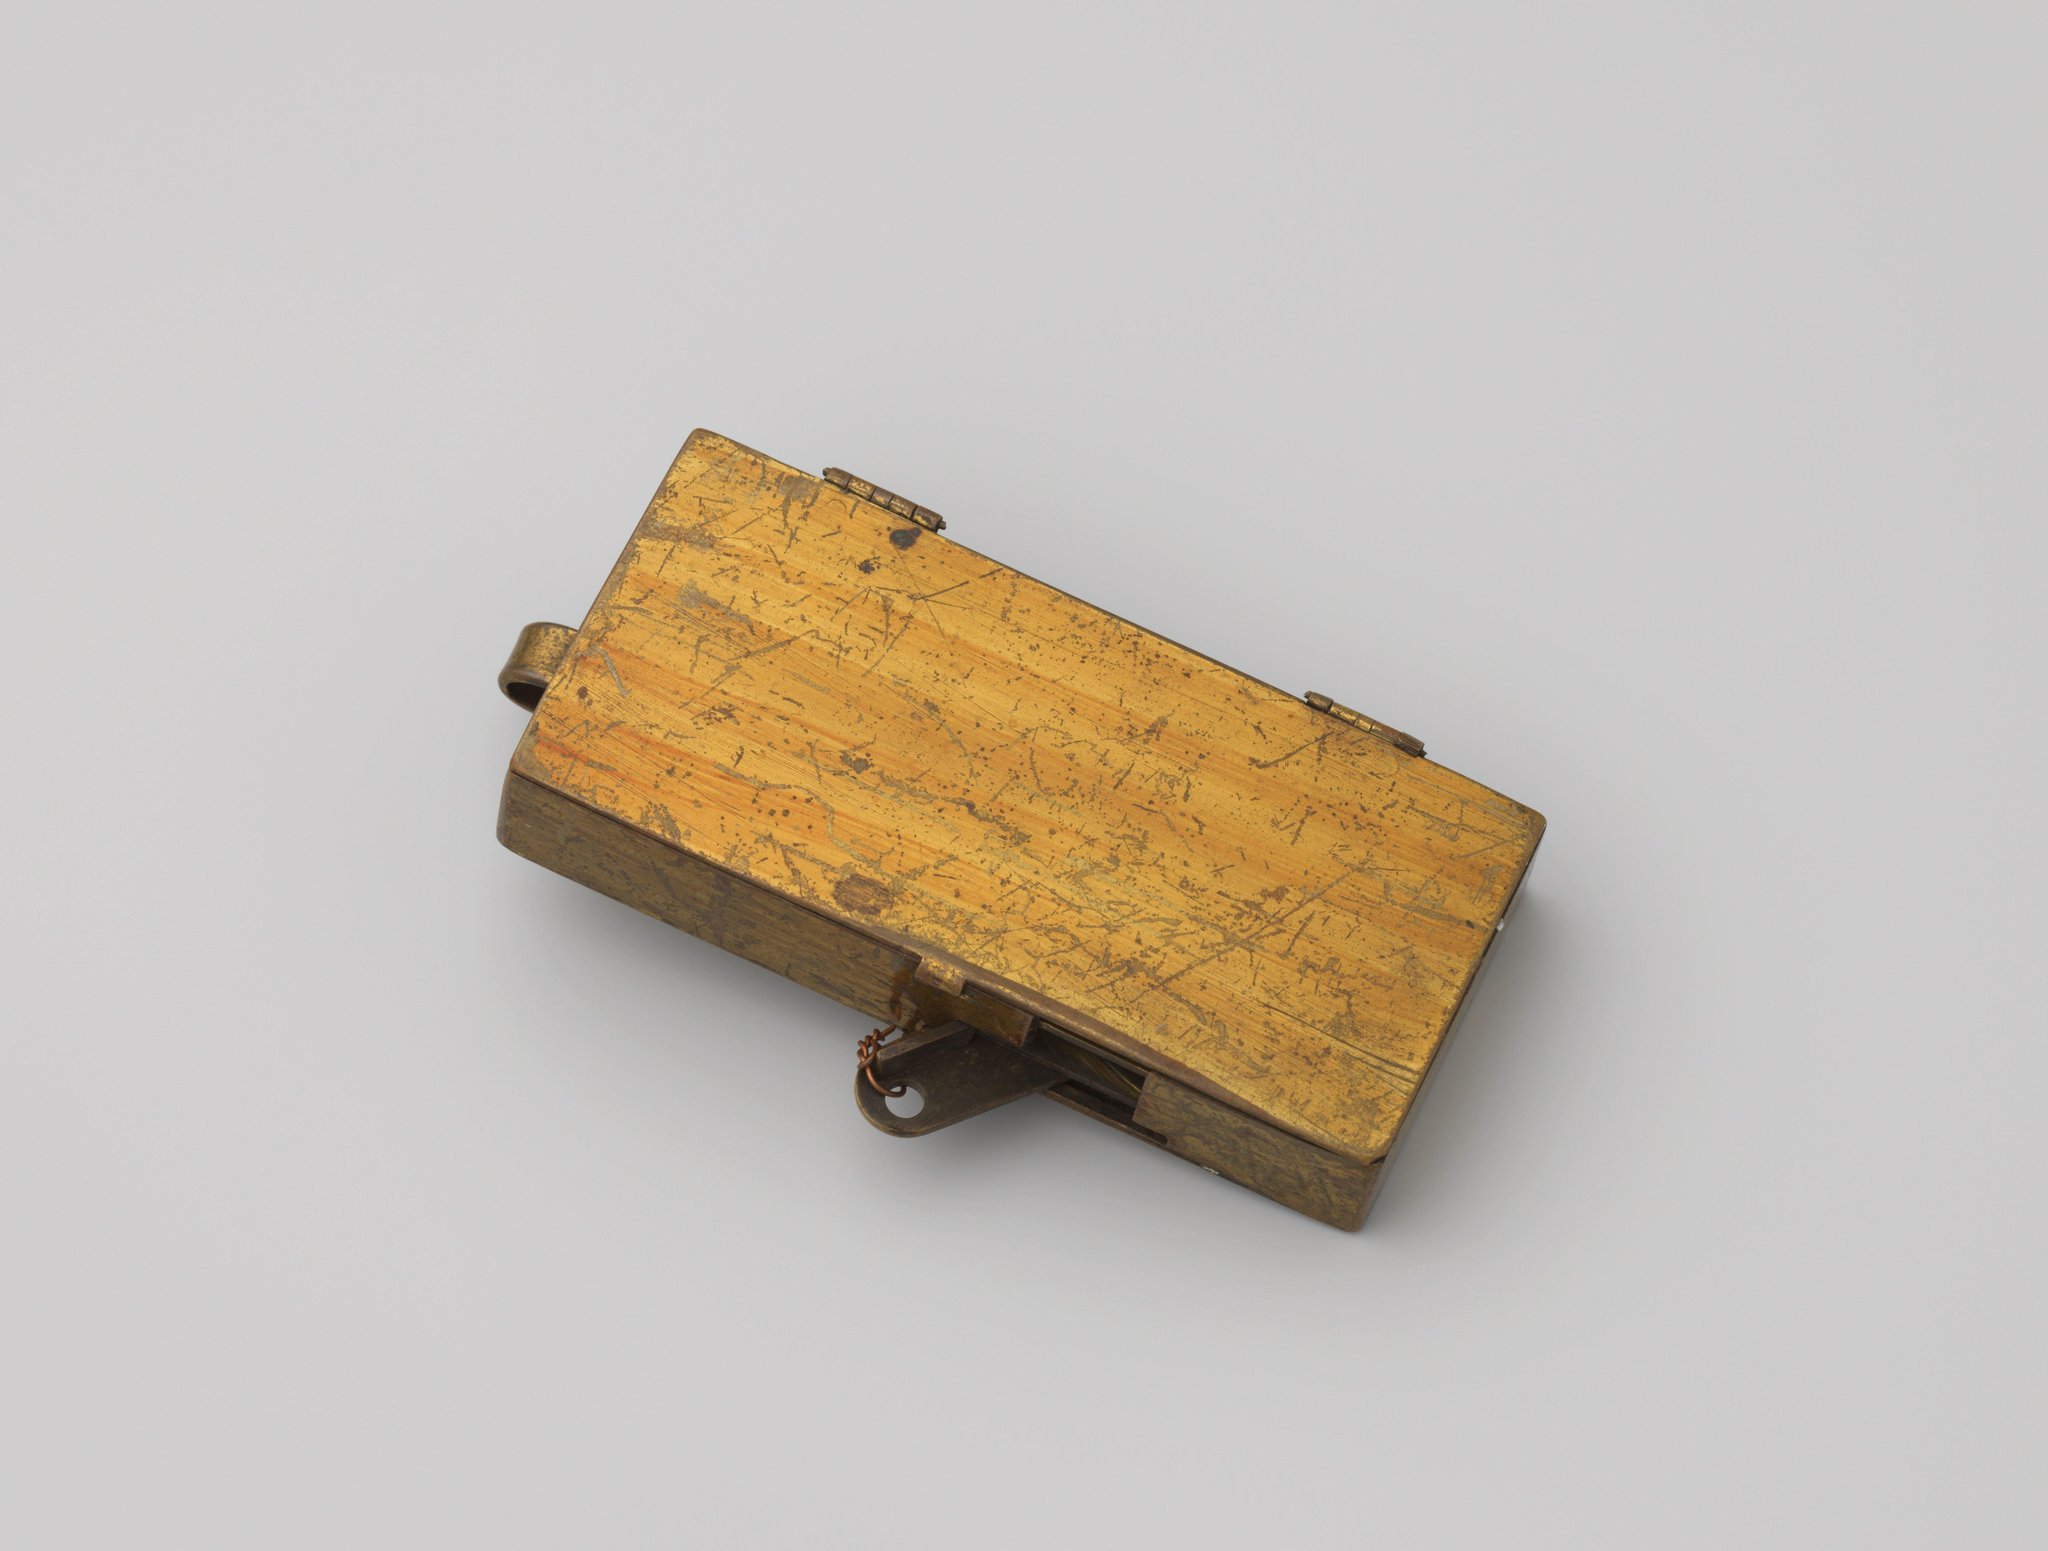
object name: pedometer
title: Koperen pedometer in rechthoekige kast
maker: Anonymous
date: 1700-1800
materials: copper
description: Koperen pedometer in rechthoekige kast. Aan de binnenzijde een wijzerplaat met vier cijferringen.